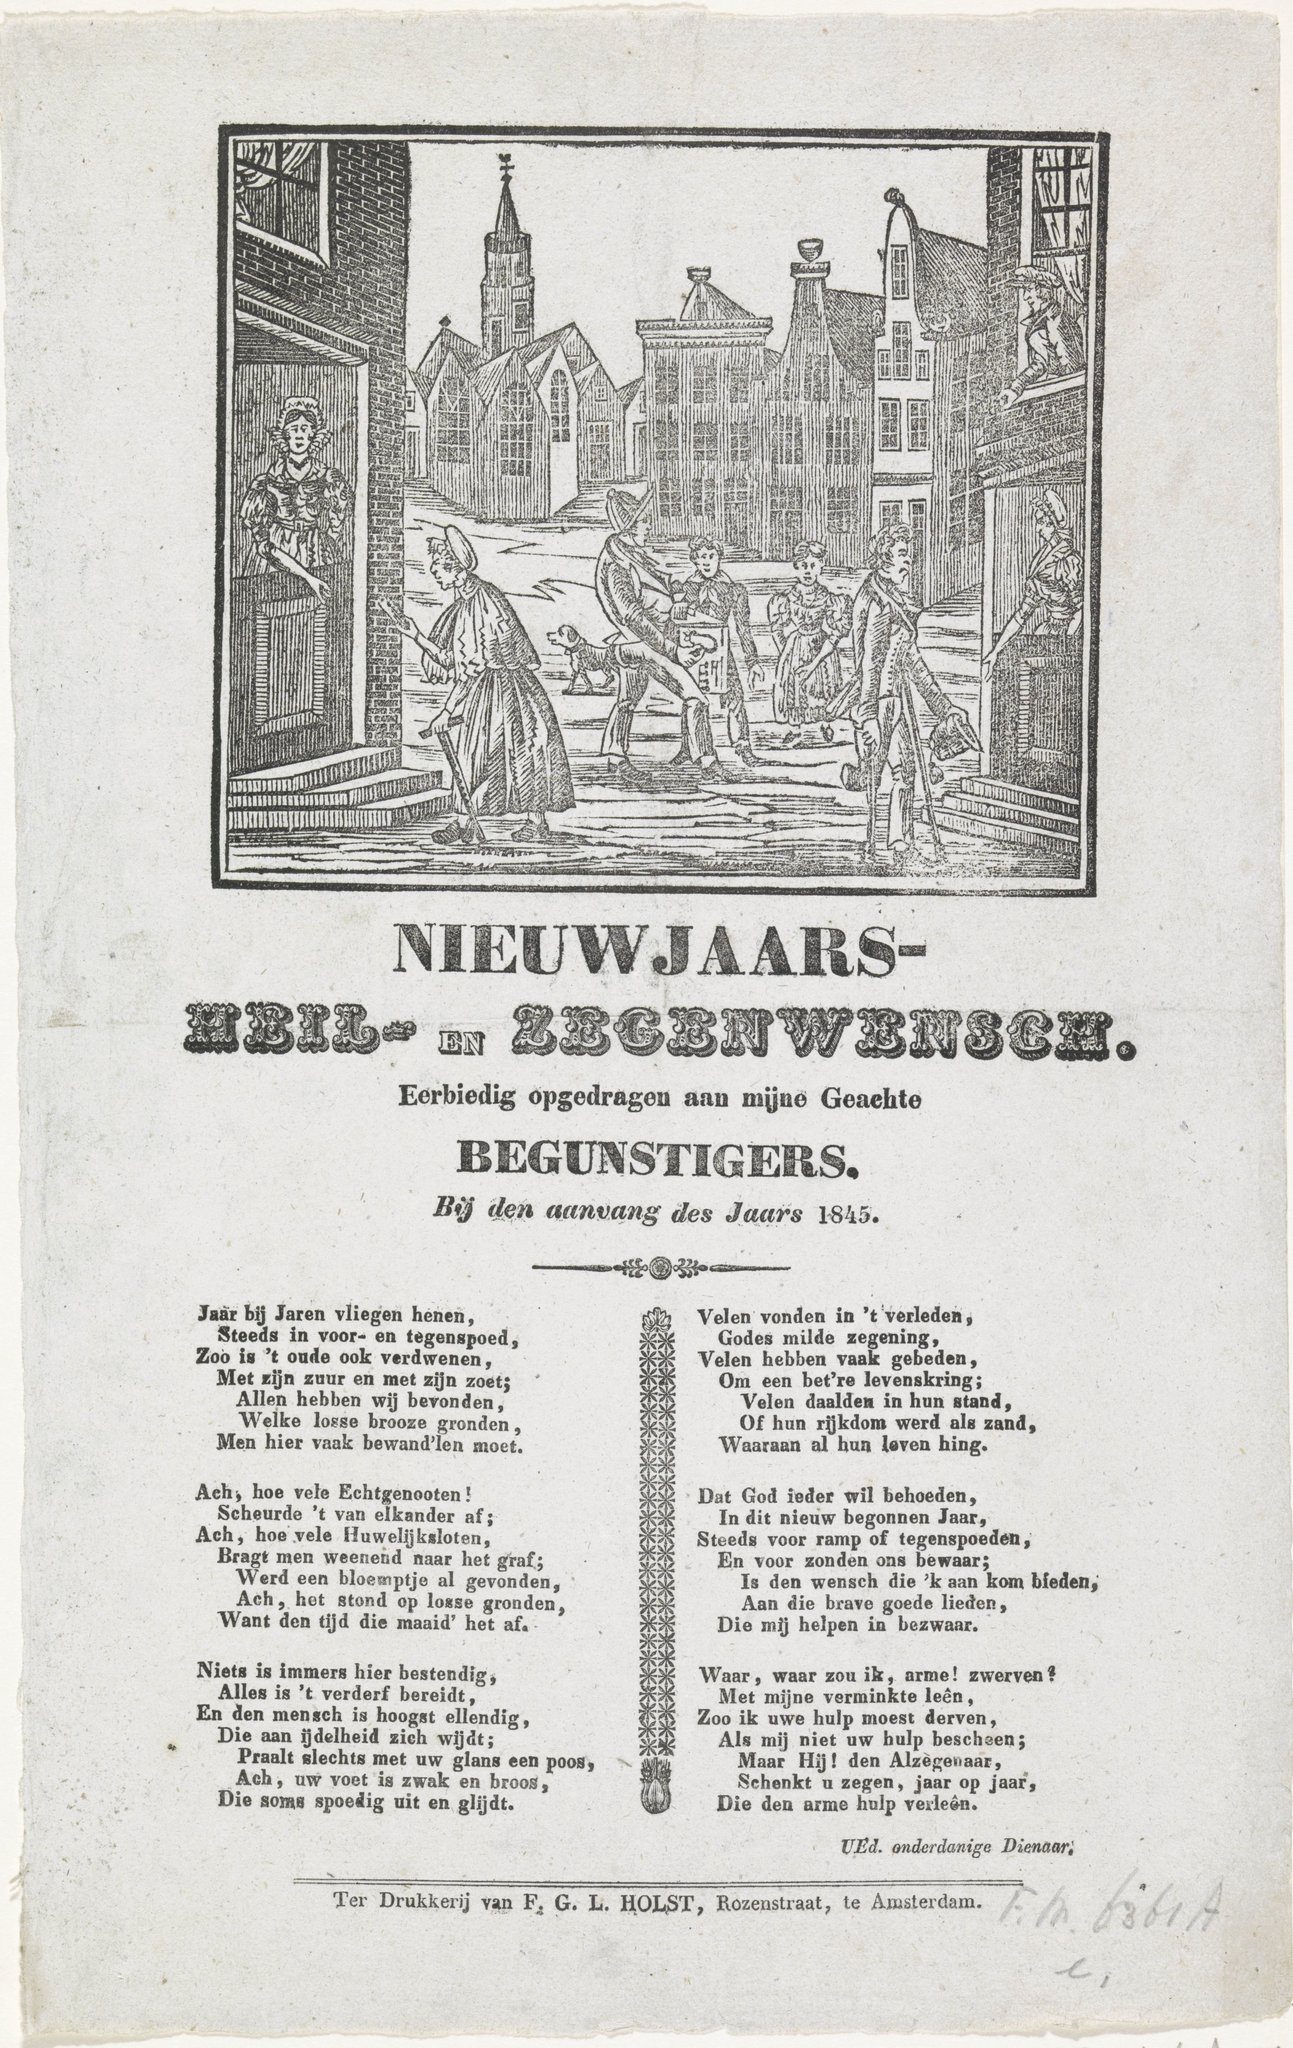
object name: print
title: Nieuwjaars- Heil- en Zegenwensch (...) aan mijne Geachte Begunstigers (...) 1845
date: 1844-1845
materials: paper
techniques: letterpress printing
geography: amsterdam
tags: canals, waters (in city) - ii - ideal city, government services, public services, waking up, amsterdam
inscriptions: collector's mark: Lugt 2228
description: Nieuwjaarswens van de Amsterdamse porders (wekkers) voor het jaar 1845. Gezicht op een Amsterdamse plein met een kerk en huizen waar een man en een vrouw aan huis geld ophalen. Met een vers in twee kolommen.